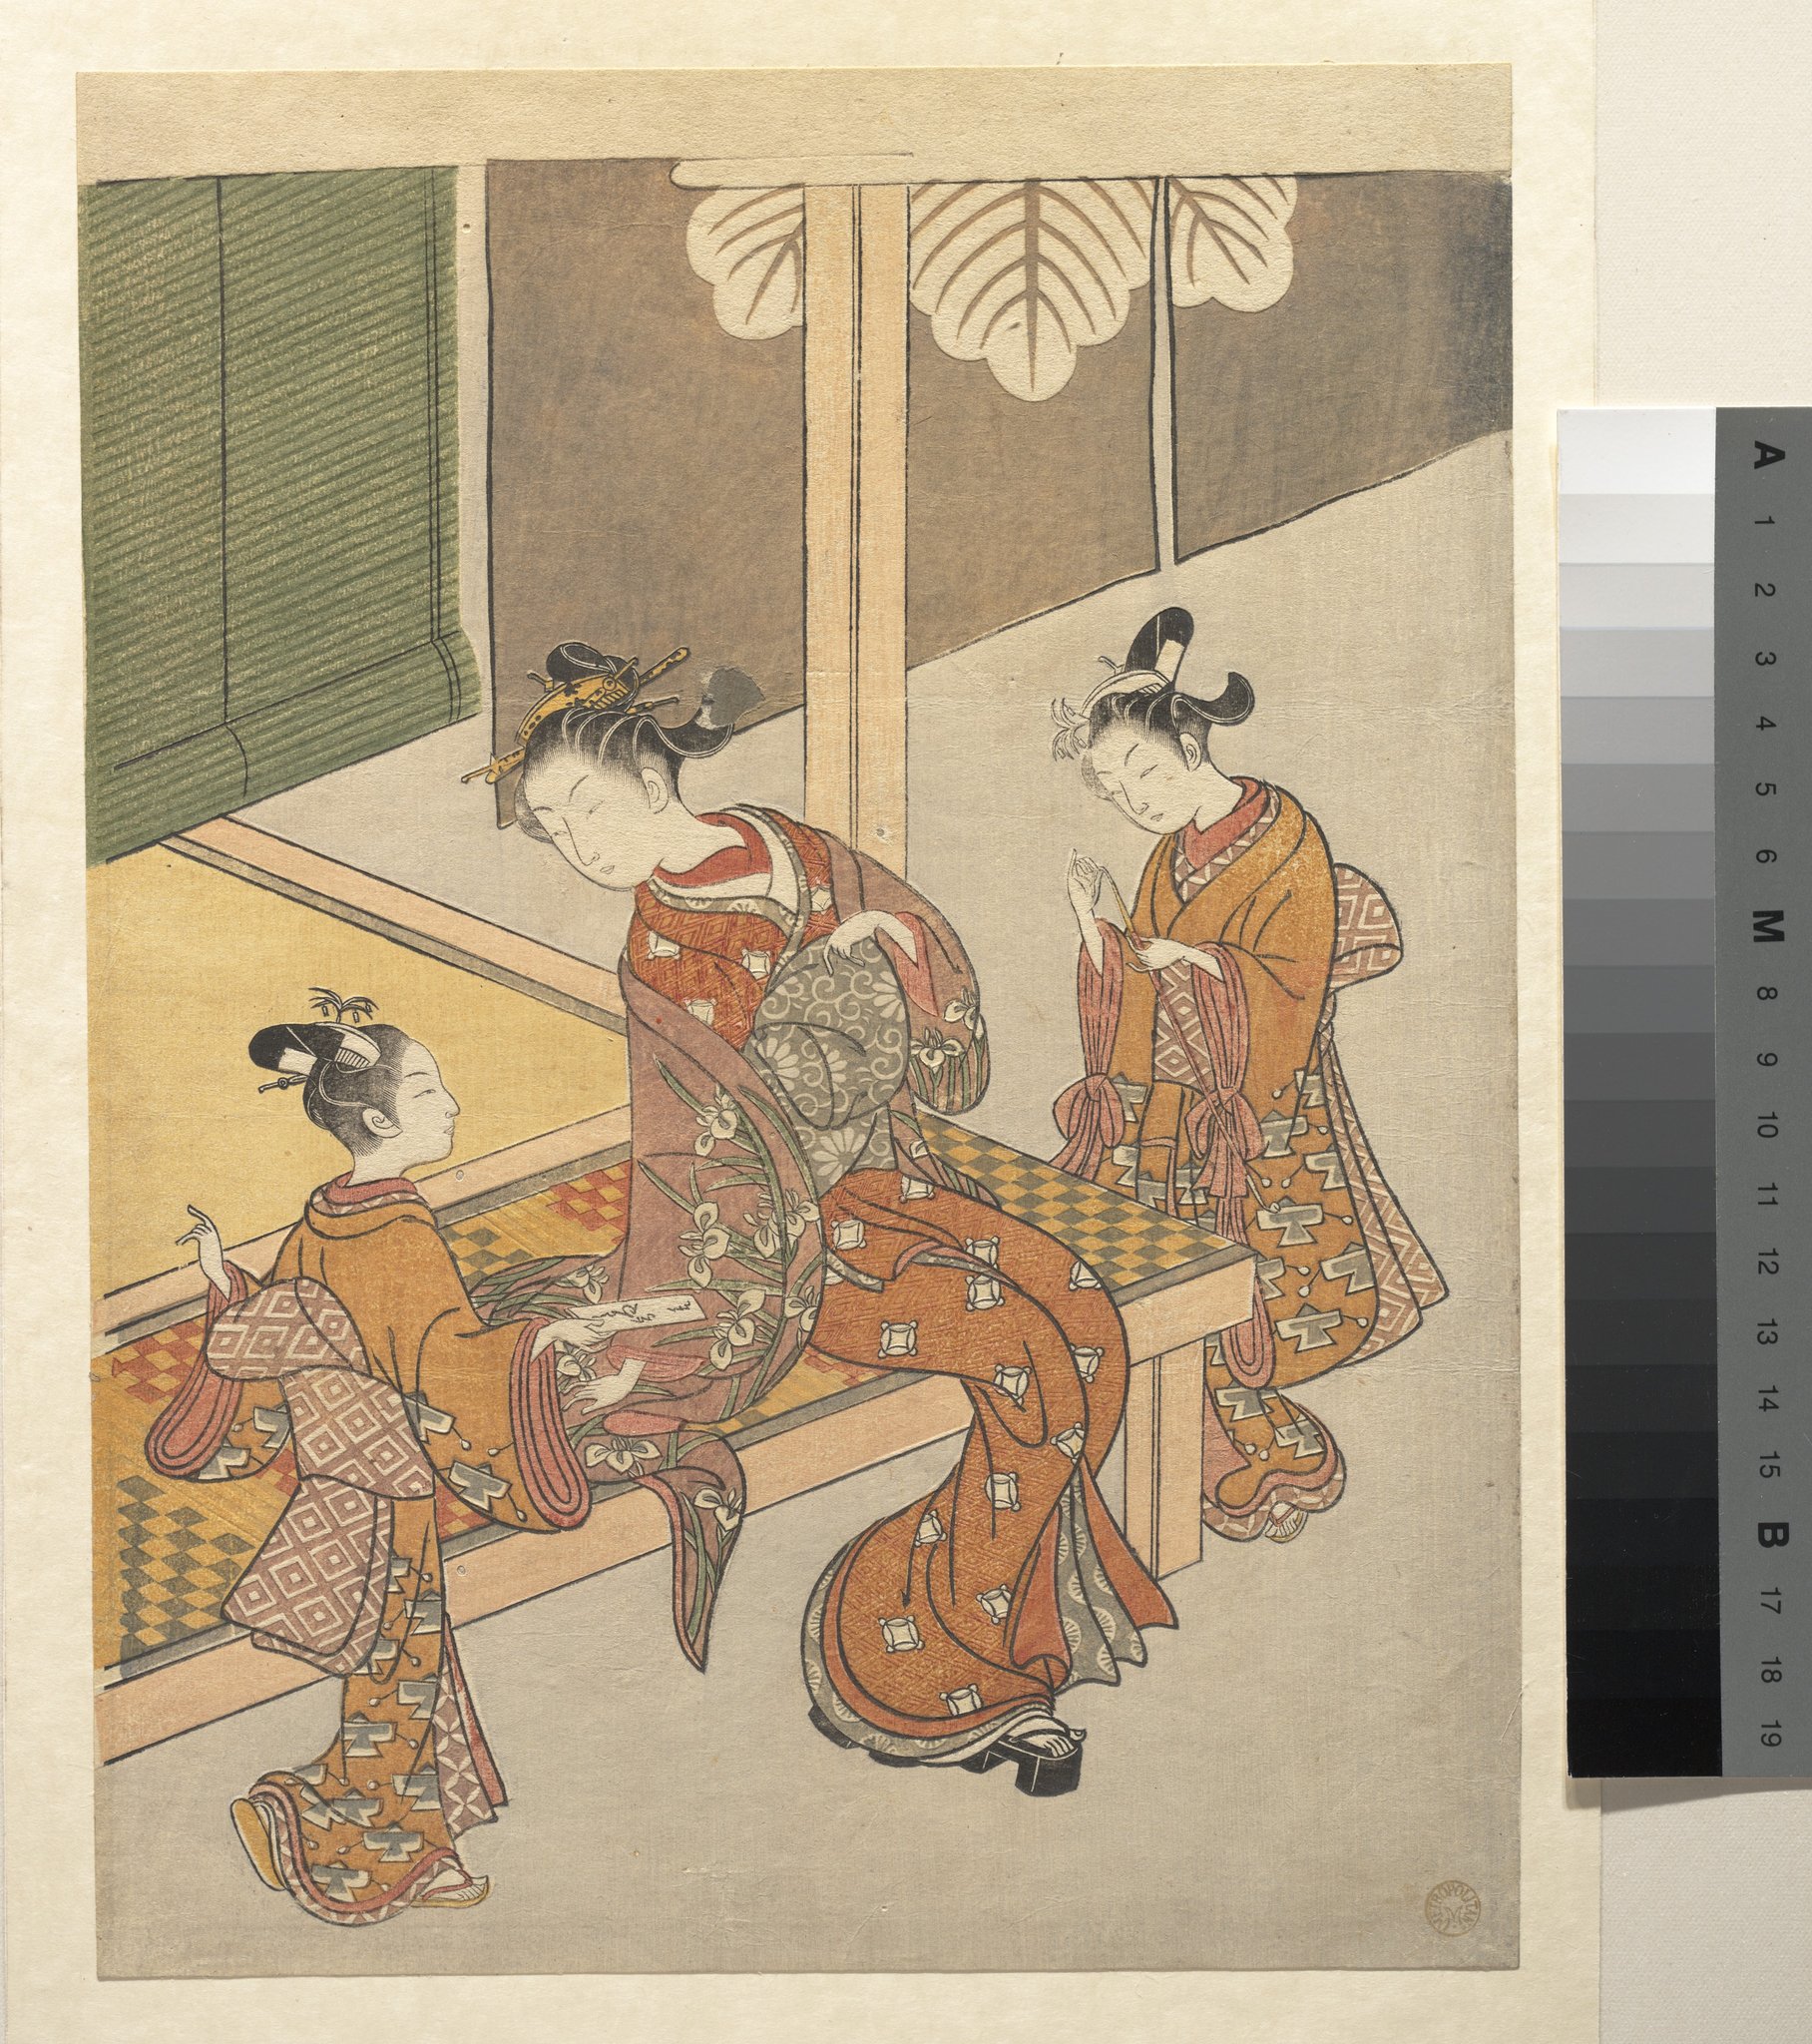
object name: print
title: On the Engawa of Tsuta-ya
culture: japanese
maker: suzuki harunobu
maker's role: artist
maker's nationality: japanese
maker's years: 1725-1770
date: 1765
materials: ink, paper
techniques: woodblock print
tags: girls,women